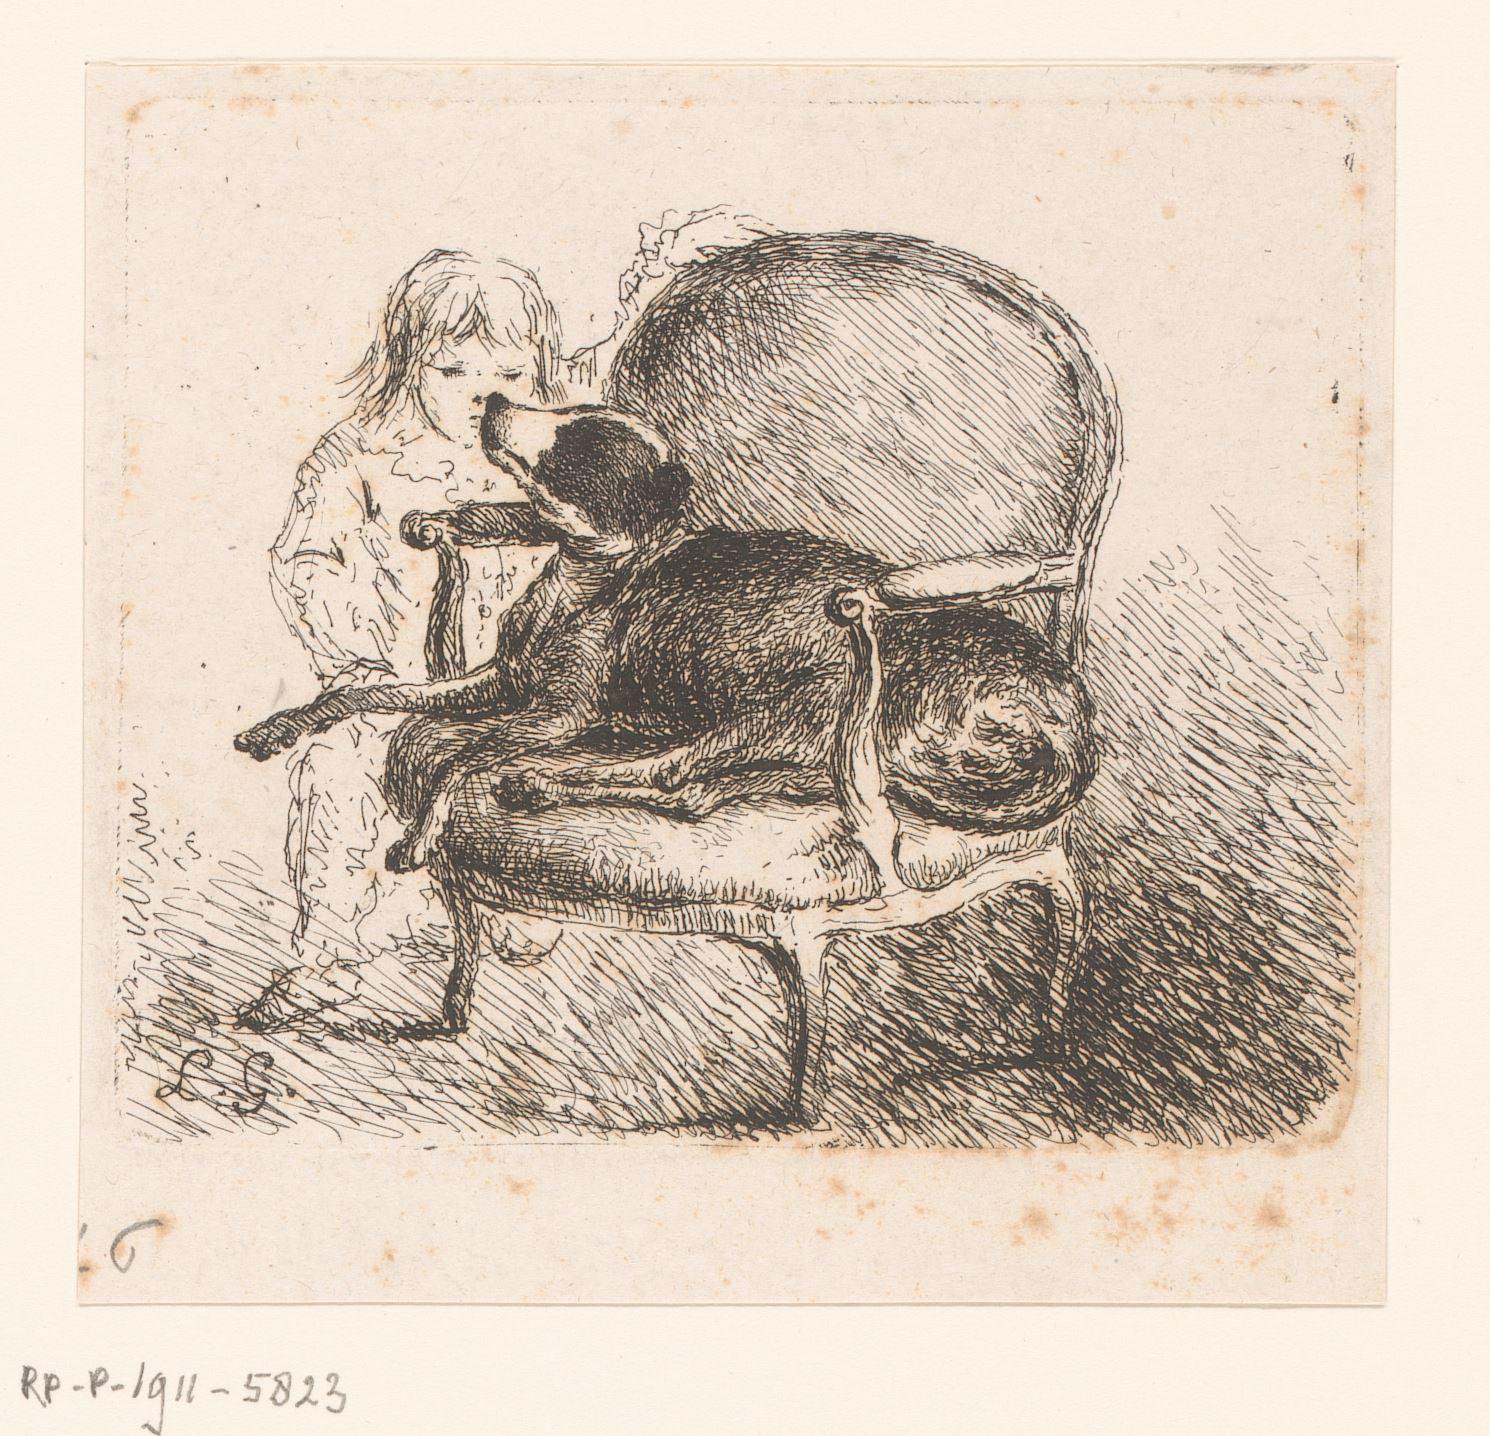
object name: print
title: Portret van Émile Legros naast een hond op een stoel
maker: sauveur legros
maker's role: print maker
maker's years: 1754-1834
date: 1764-1834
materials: paper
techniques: etching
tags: child, historical persons, dog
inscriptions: collector's mark: Lugt 2228